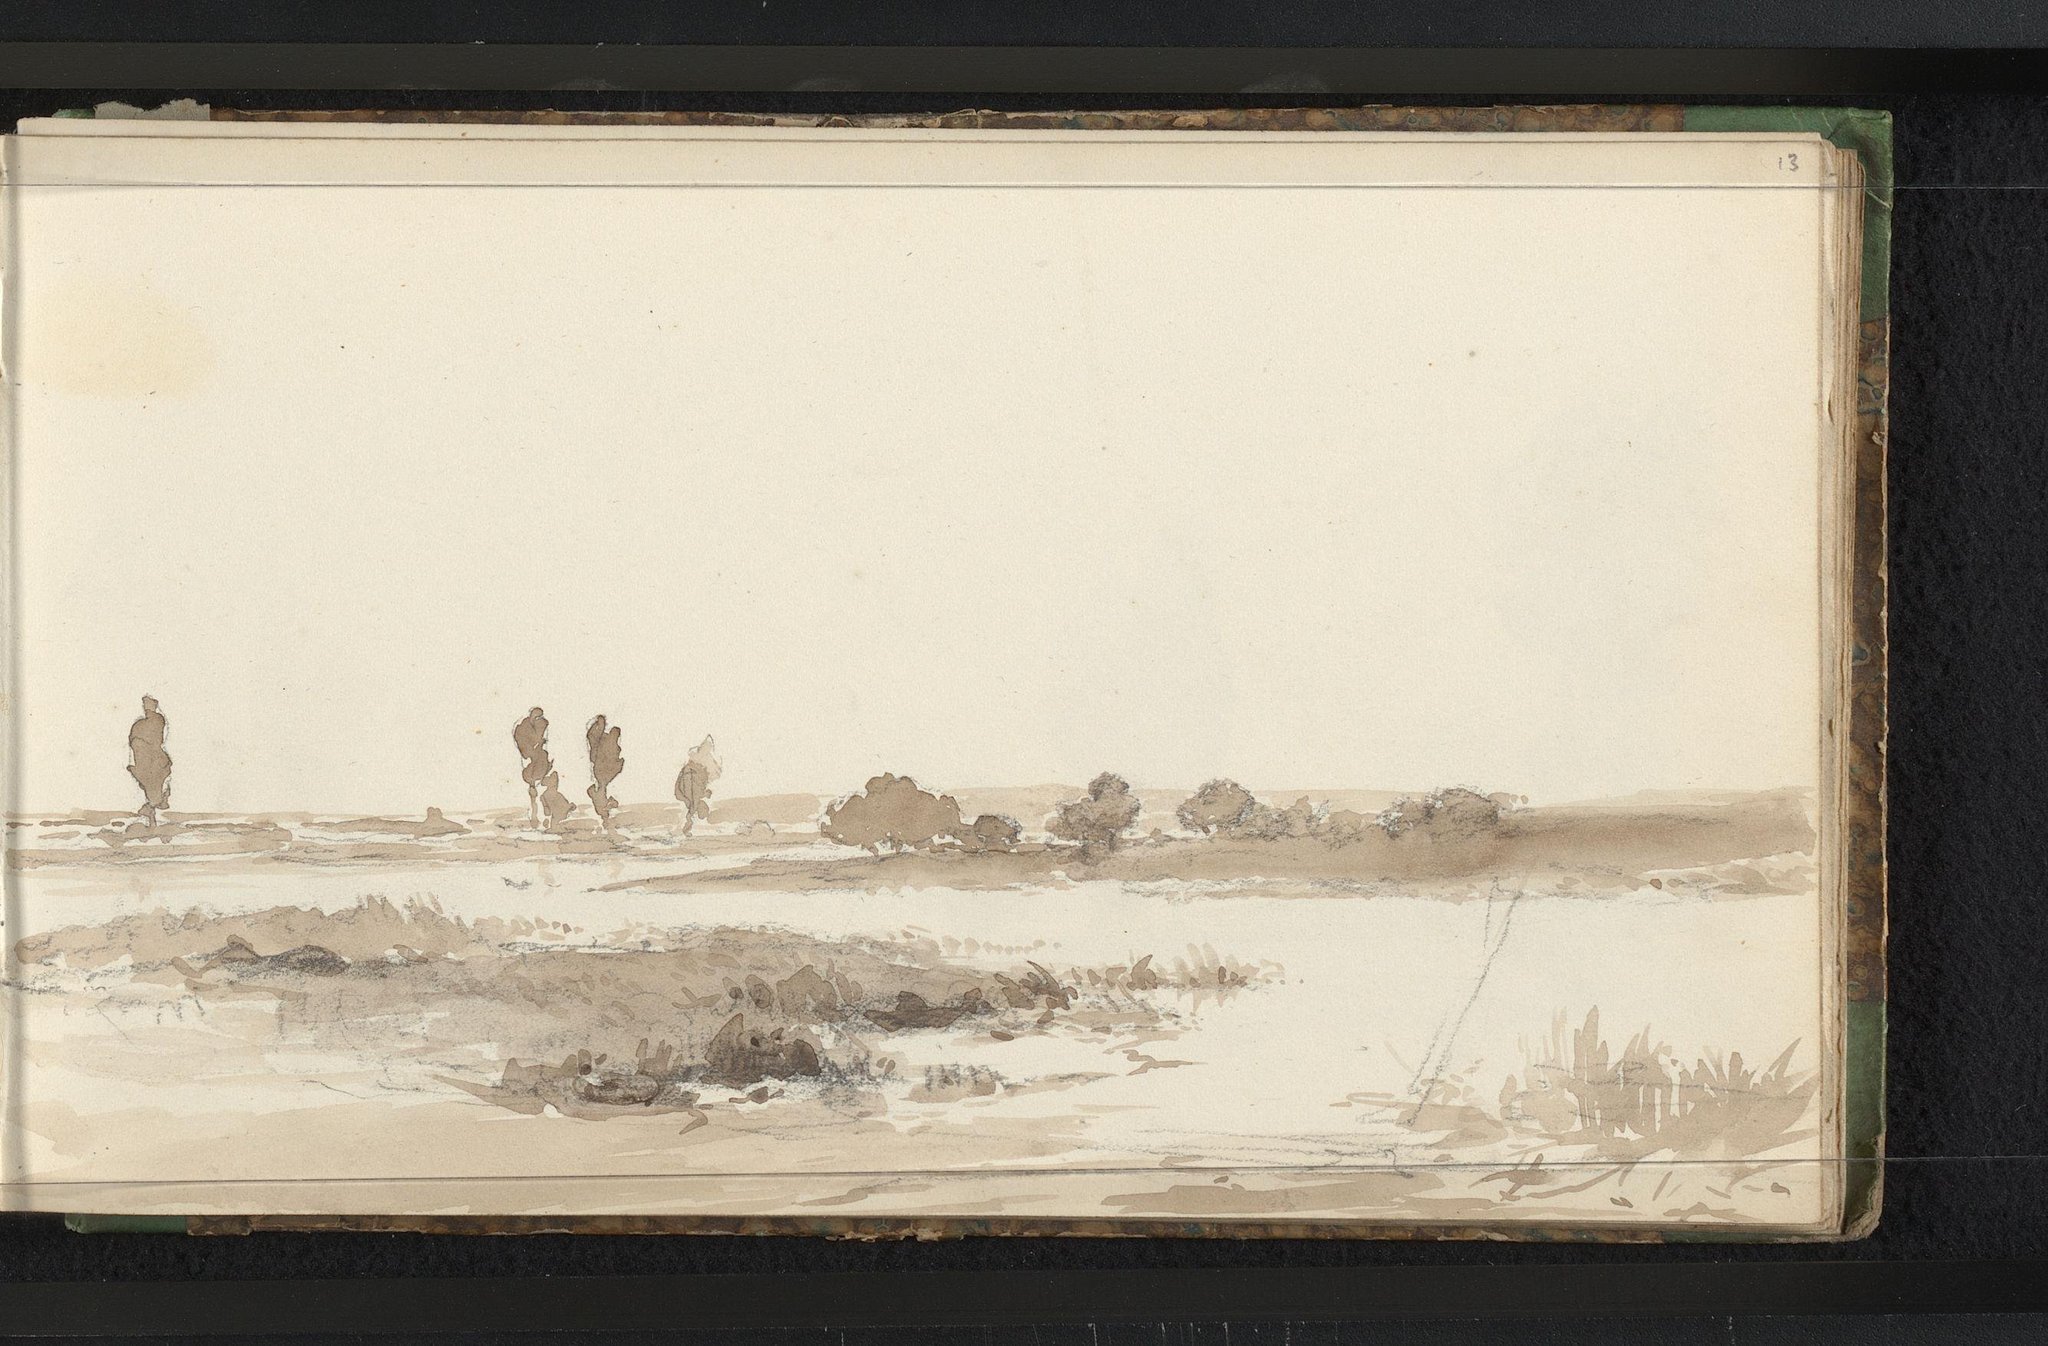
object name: sketchbook leaf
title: Landschap met water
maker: jan bedijs tom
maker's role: draughtsman, painter, print maker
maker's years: 1813-1894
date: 1828-1894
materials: paper, pencil, watercolor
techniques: brush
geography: the hague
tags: trees, landscapes, landscapes with waters, waterscapes, seascapes (in the temperate zone), artist (in general) making preliminary designs, sketching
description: Pagina 13 recto uit een schetsboek met 50 bladen.